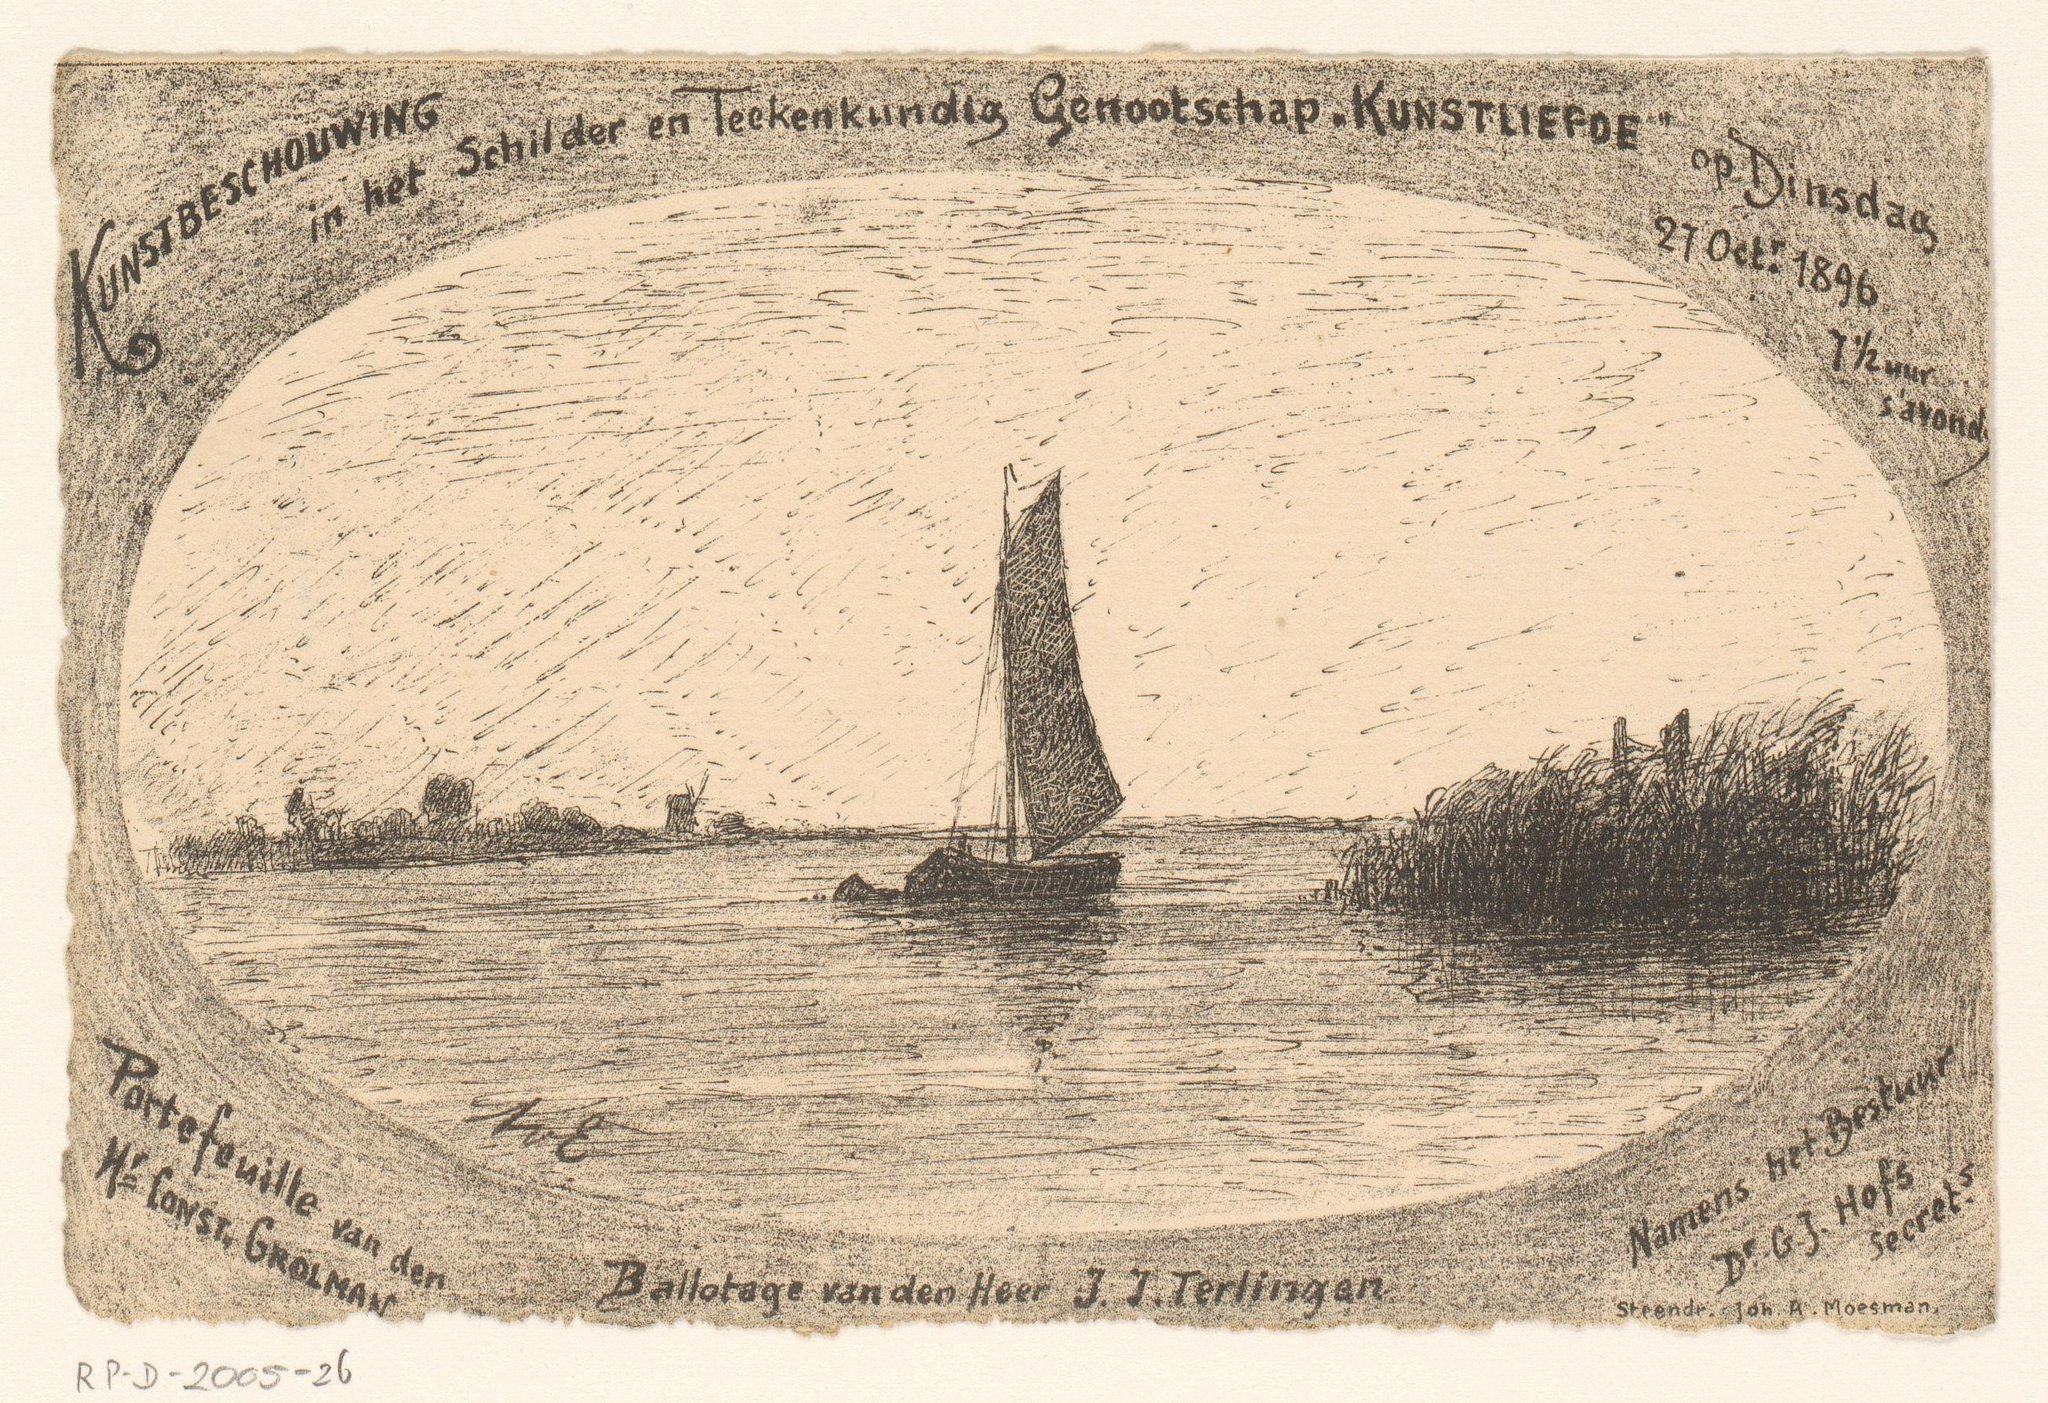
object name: invitation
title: Uitnodiging van Schilder- en Teekenkundig Genootschap "Kunstliefde" voor een kunstbeschouwing, 27 oktober 1896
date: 1810-1896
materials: paper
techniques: lithograph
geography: utrecht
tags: criticizing and discussing art, art criticism, circle, club of artists, collecting and exhibiting products of the fine arts, sailing-ship, sailing-boat, river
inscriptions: collector's mark: Lugt 2228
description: Zeilschip op het water. Uitnodiging van Schilder- en Teekenkundig Genootschap "Kunstliefde" voor een kunstbeschouwing op 27 oktober 1896 van de portefeuille van de dhr. Const. Grolman.